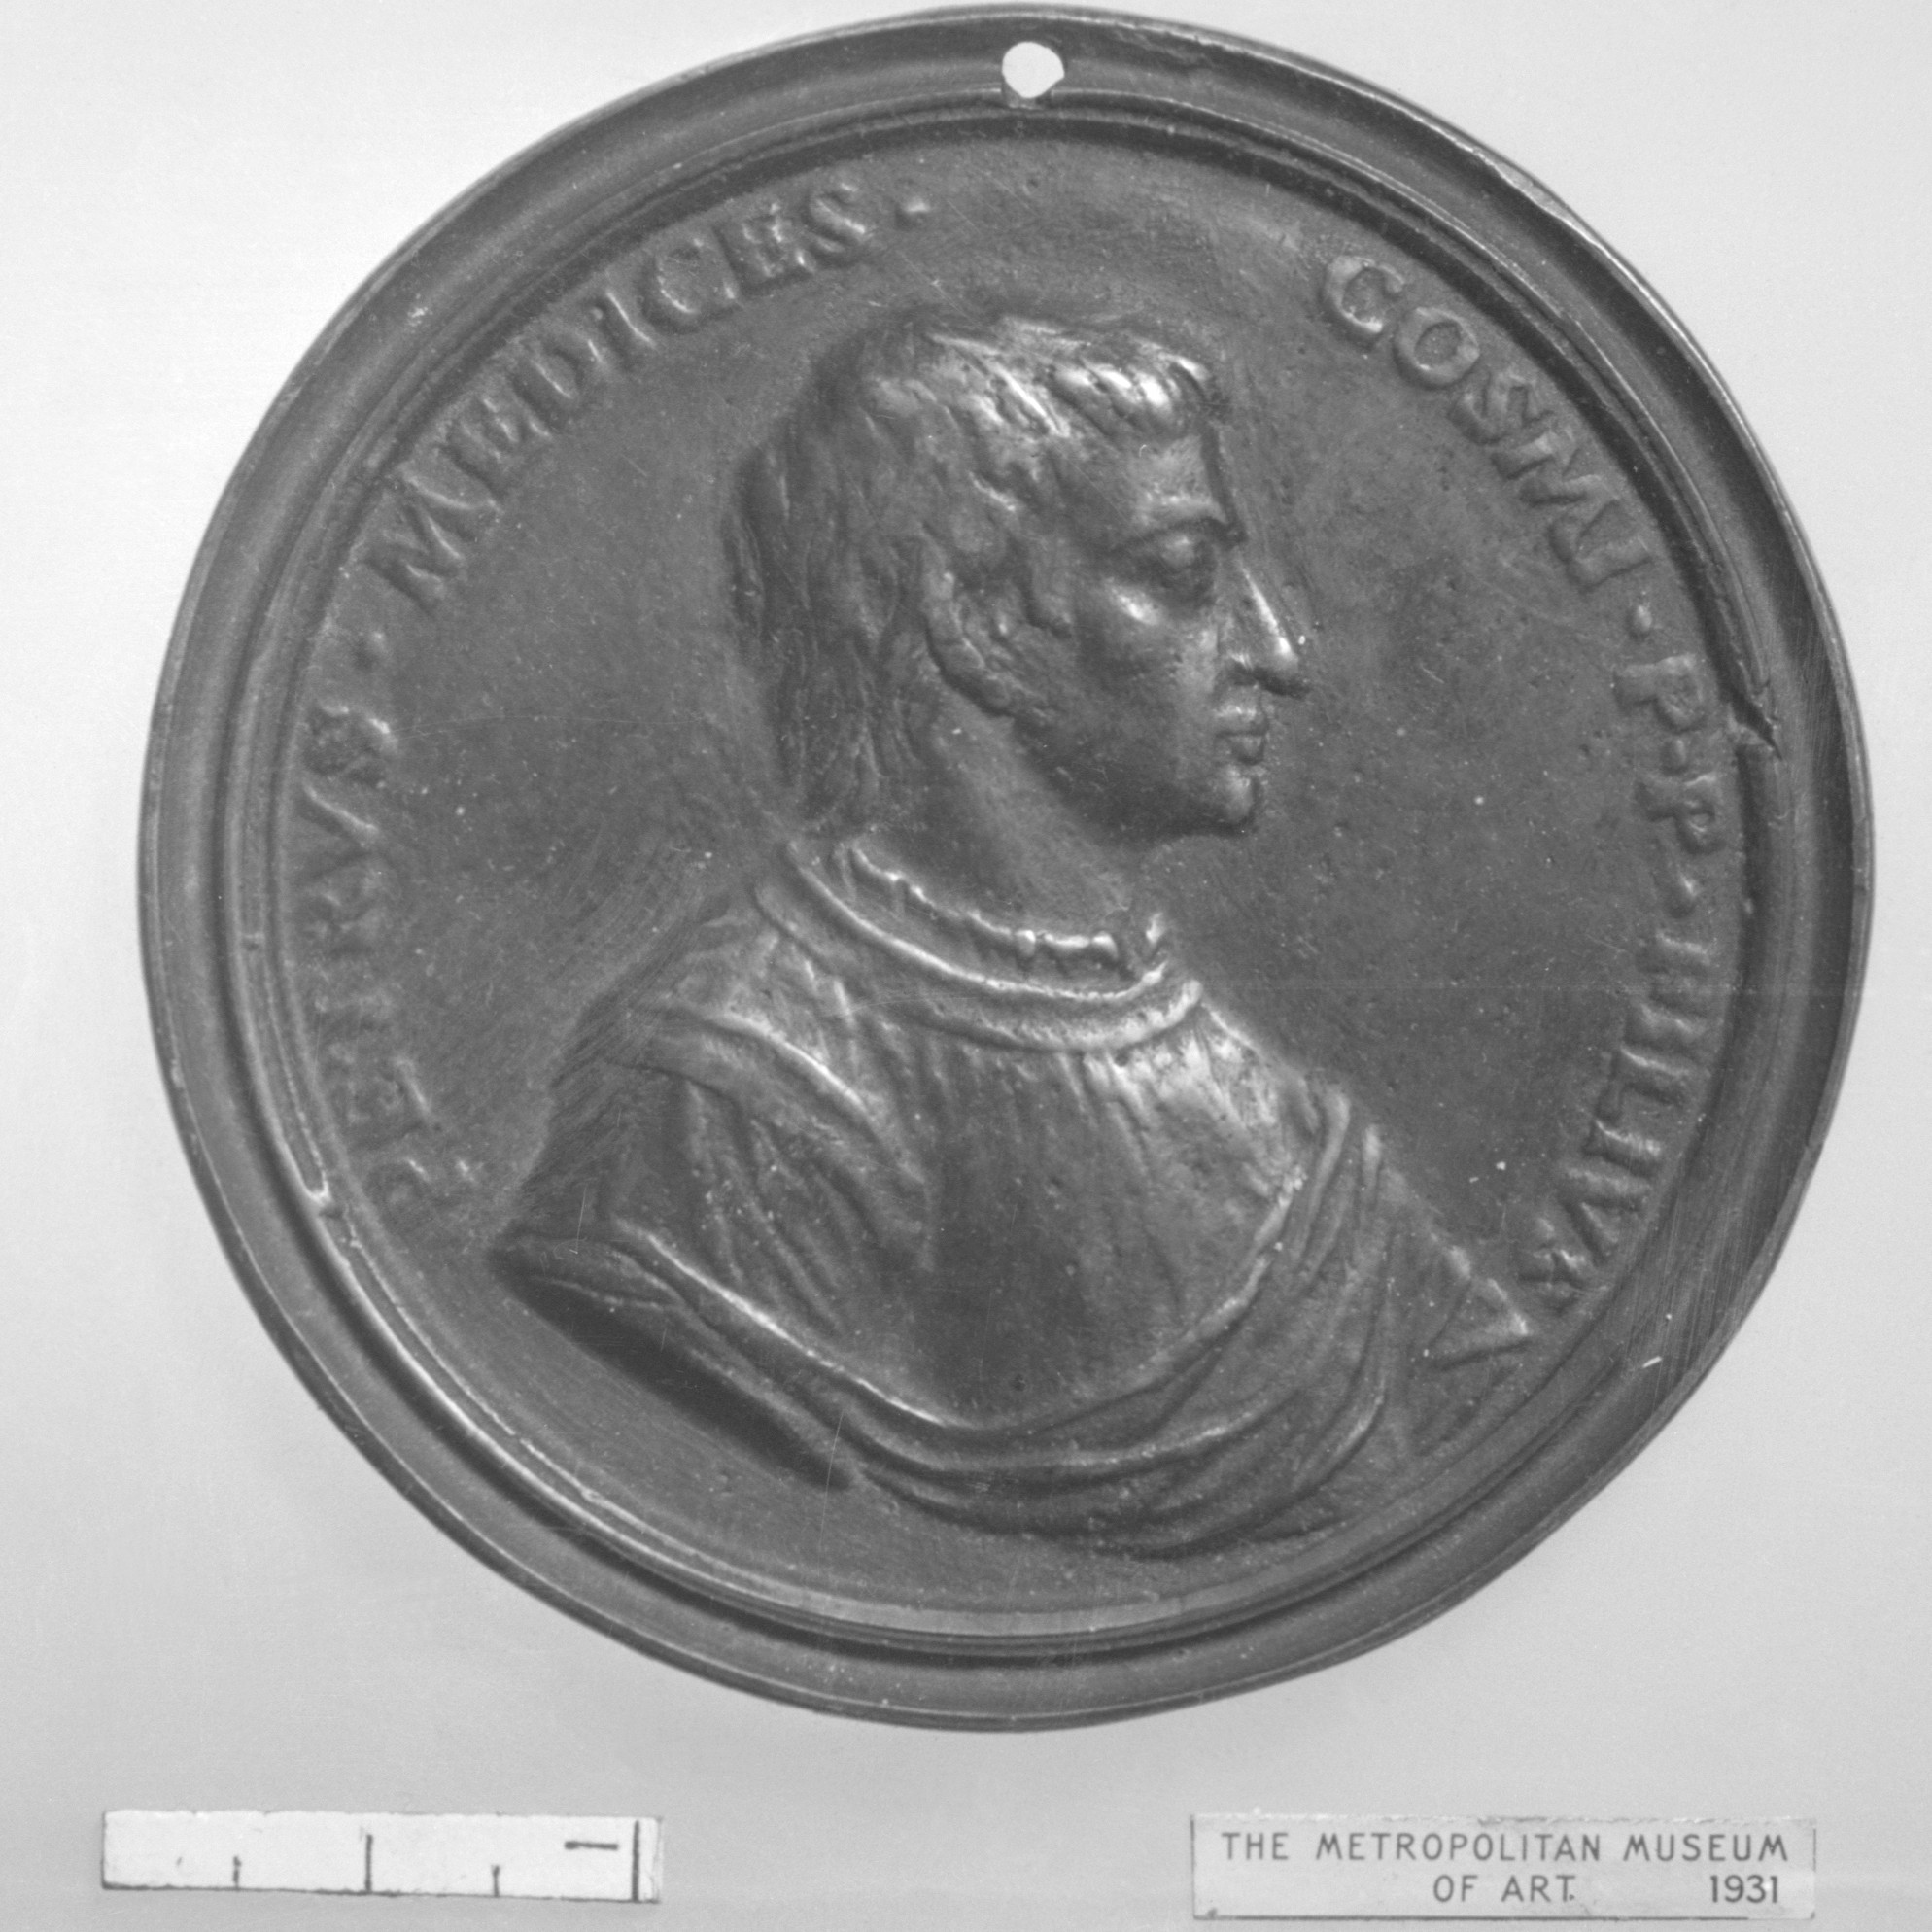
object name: medal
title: Piero I Medici (1464–69)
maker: massimiliano soldani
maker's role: artist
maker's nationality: italian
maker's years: 1656-1740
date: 1601-1800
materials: bronze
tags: eagles,men,profiles